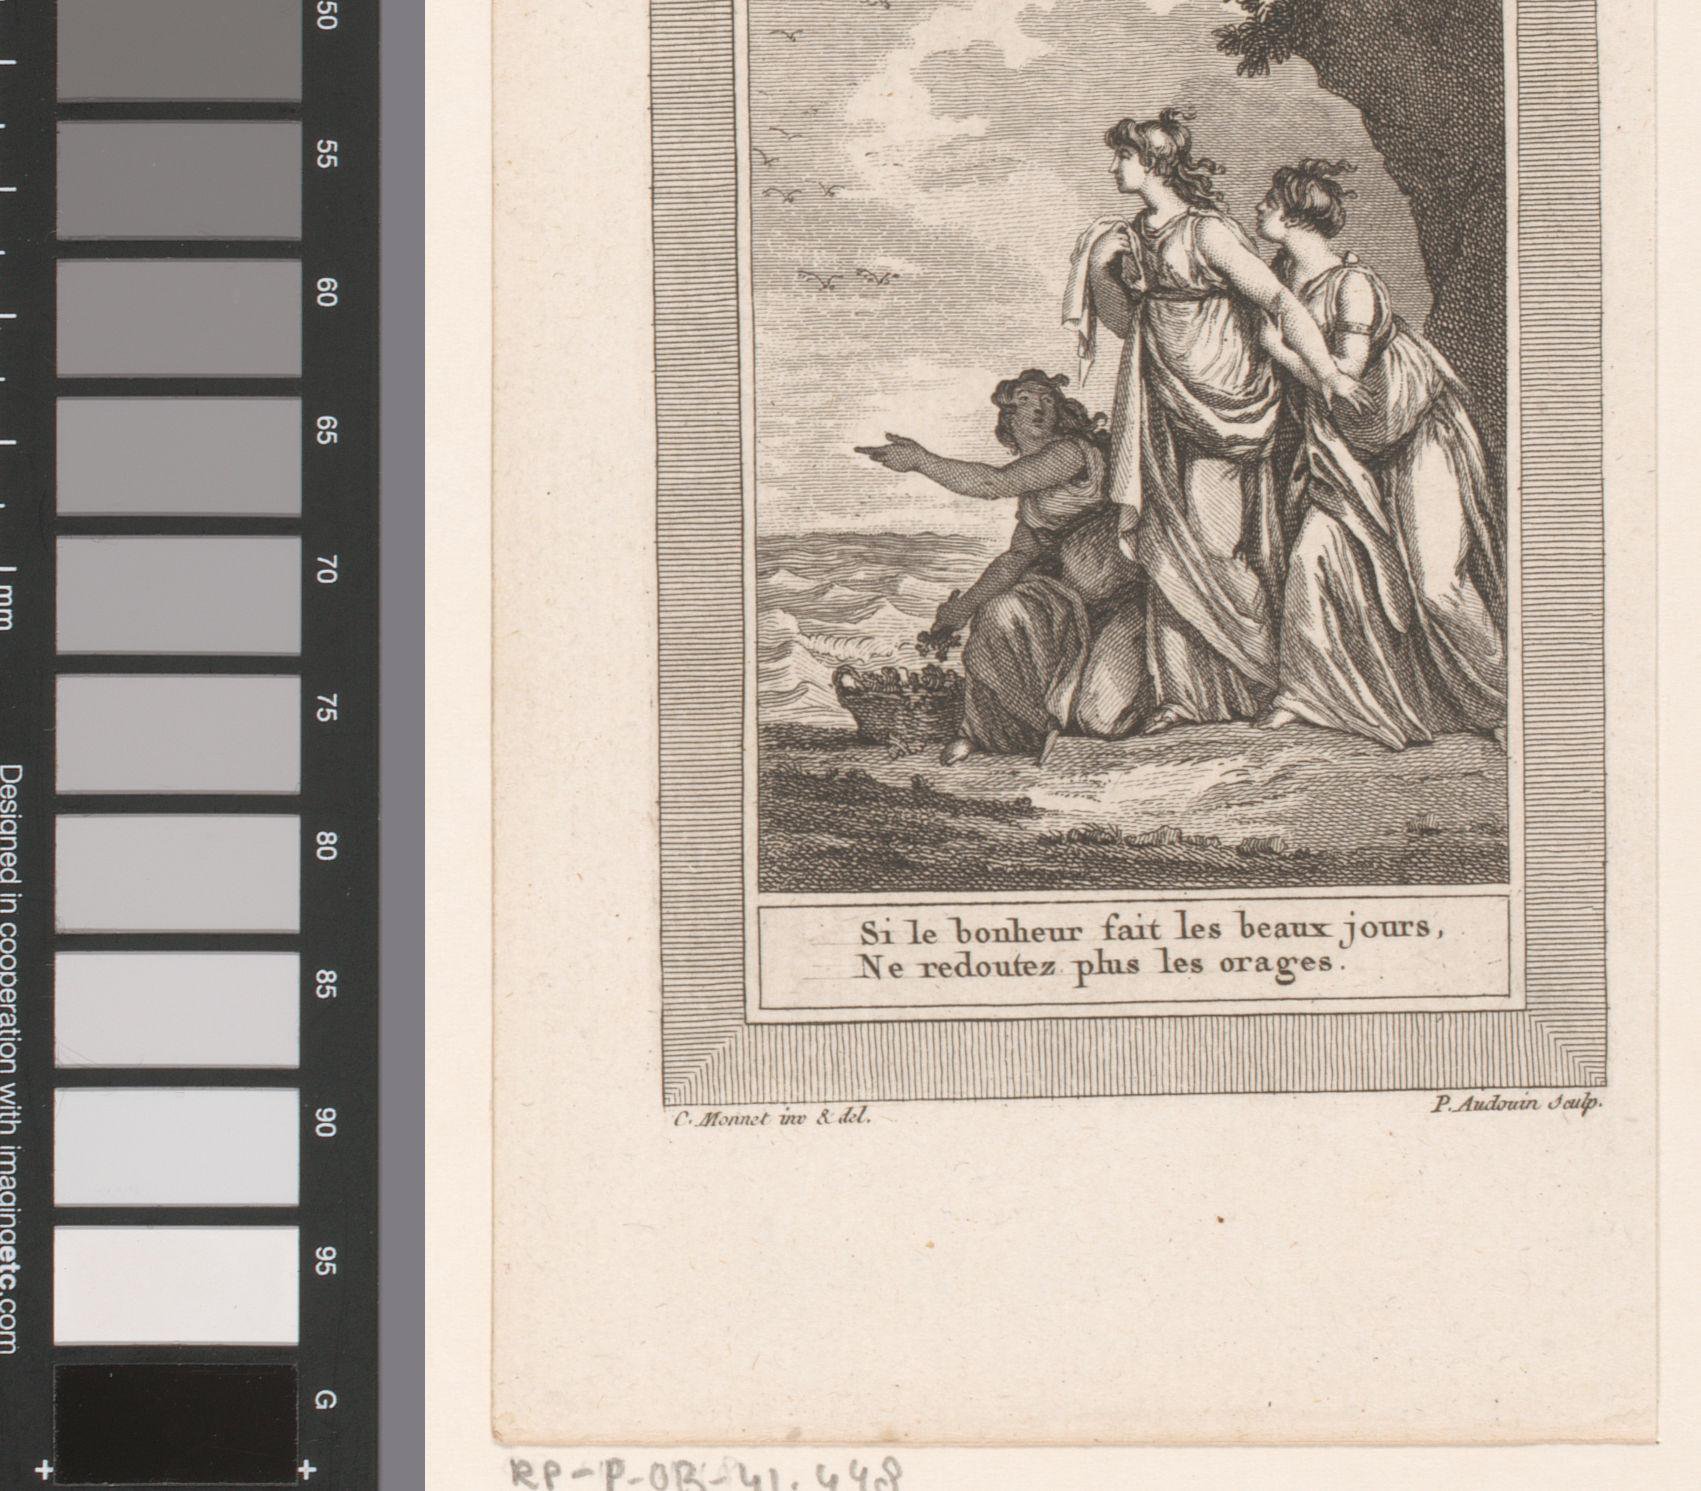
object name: book illustration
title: Alkyone kijkt uit over zee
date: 1801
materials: paper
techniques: engraving, etching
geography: paris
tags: alcyone (pleiad) (+ variant)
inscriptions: collector's mark: Lugt 2228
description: Prent uit: C.A. Demoustier. Lettres a Émilie, sur la mythologie. Paris: A.A. Renouard, 1801.